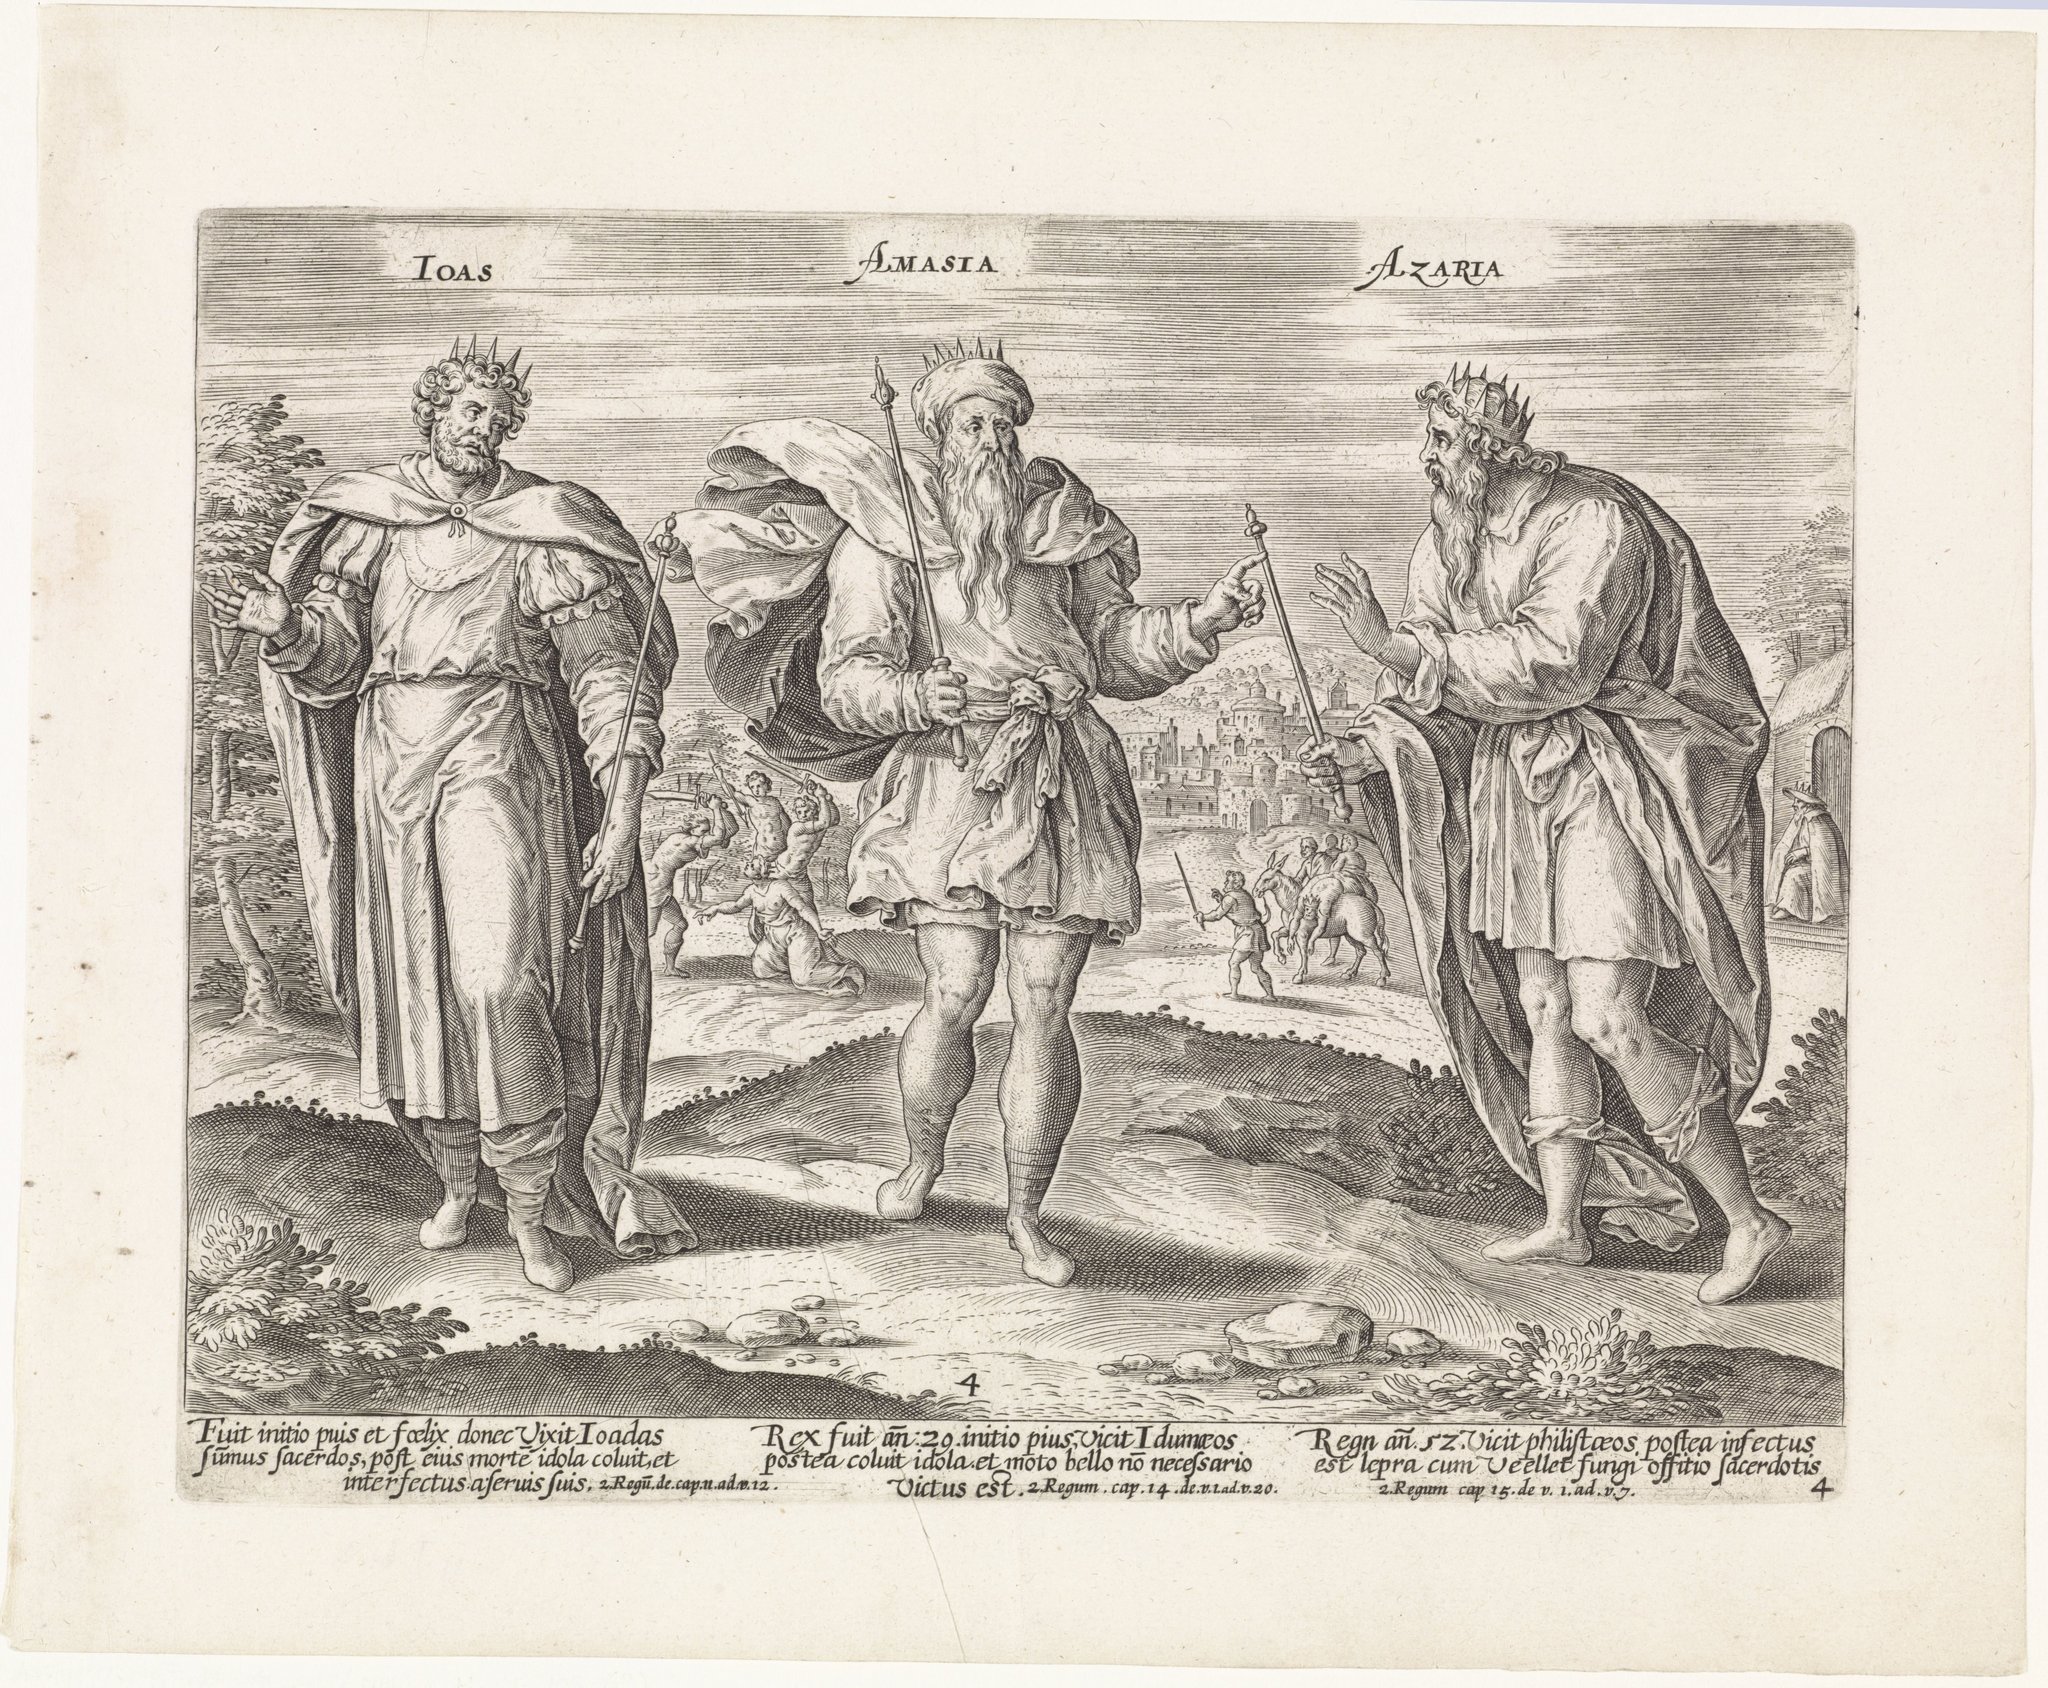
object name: print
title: Joas, Amasja en Azarja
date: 1585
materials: paper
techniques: engraving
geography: amsterdam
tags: death of athalia: she is seized by soldiers, brought to the palace and killed at the horse gate, story of joash, son of ahaziah, king of judah (2 kings 11:4 - 12:21; 2 chronicles 23-24), amaziah is assassinated in lachish; his body is carried back to jerusalem on a horse, story of uzziah (azariah), son of amaziah, king of judah (2 kings 15:1-7; 2 chronicles 26), story of amaziah, son of joash, king of judah (2 kings 14:1-21; 2 chronicles 25), kings of israel and judah ~ the old testament (not in biblical context)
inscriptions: collector's mark: Lugt 2228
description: De koningen Joas, Amasja en Azarja. Op de achtergrond enkele belangrijke gebeurtenissen uit hun leven. Links op de achtergrond wordt Joas' voorganger koningin Atalja ter dood gebracht. Midden op de achtergrond wordt de vermoorde koning Amasja te paard naar Jeruzalem gebracht. Rechts op de achtergrond zit koning Azarja bedekt bij een poort. Hij leefde in afzondering omdat hij leed aan huidvraat. Onder de voorstelling verwijzingen naar de Bijbelteksten in het Latijn.